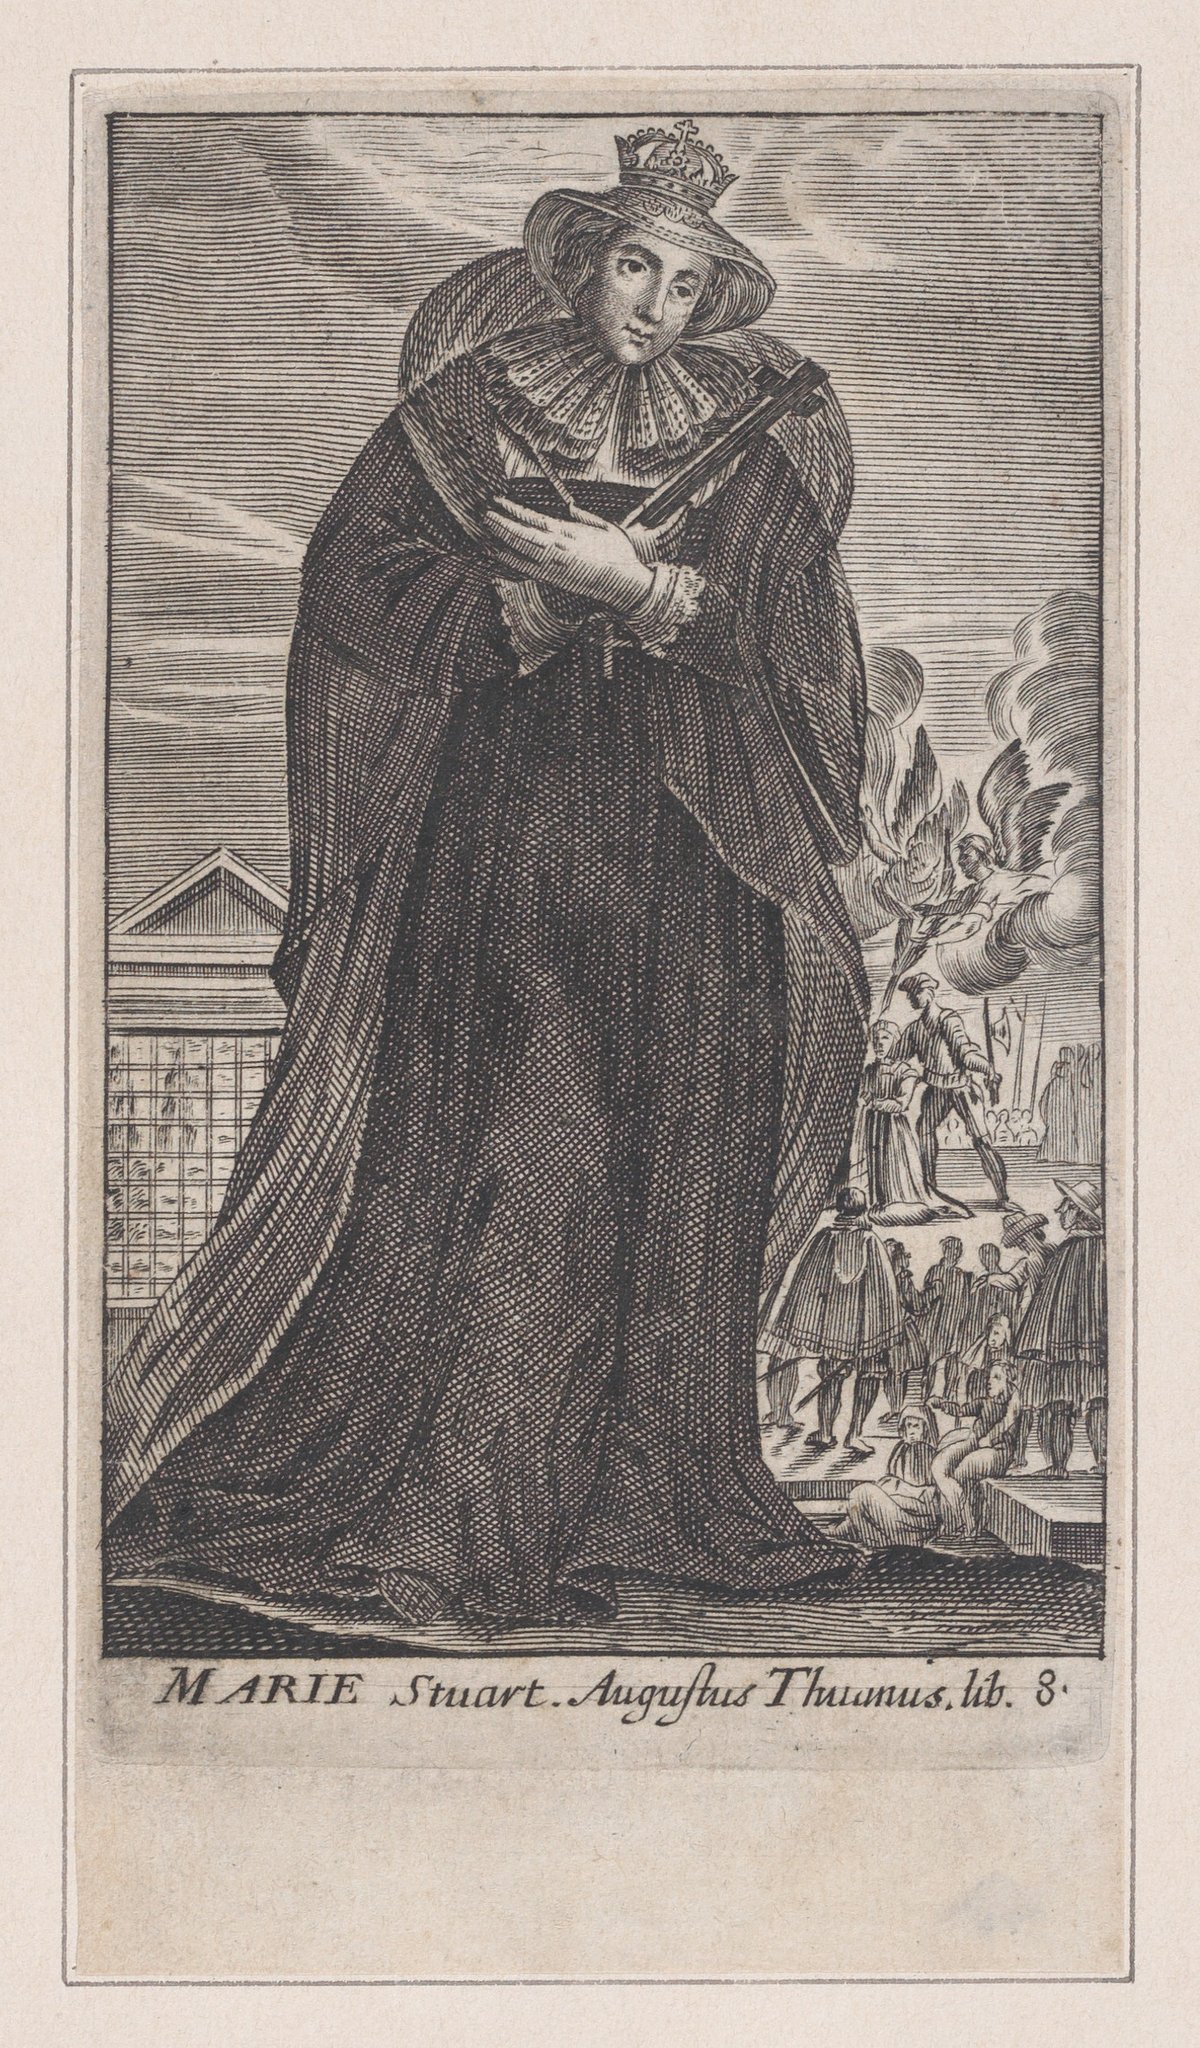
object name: print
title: Mary, Queen of Scots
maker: claude vignon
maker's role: artist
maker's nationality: french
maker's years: 1593-1670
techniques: engraving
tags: queens,portraits,women,cross,mary queen of scots